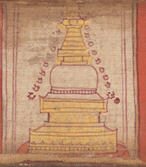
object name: folio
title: Folio from a Manuscript of the Ashtasahasrika Prajnaparamita (Perfection of Wisdom)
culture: indian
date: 1101-1200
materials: ink, leaf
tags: buddhism,stupas